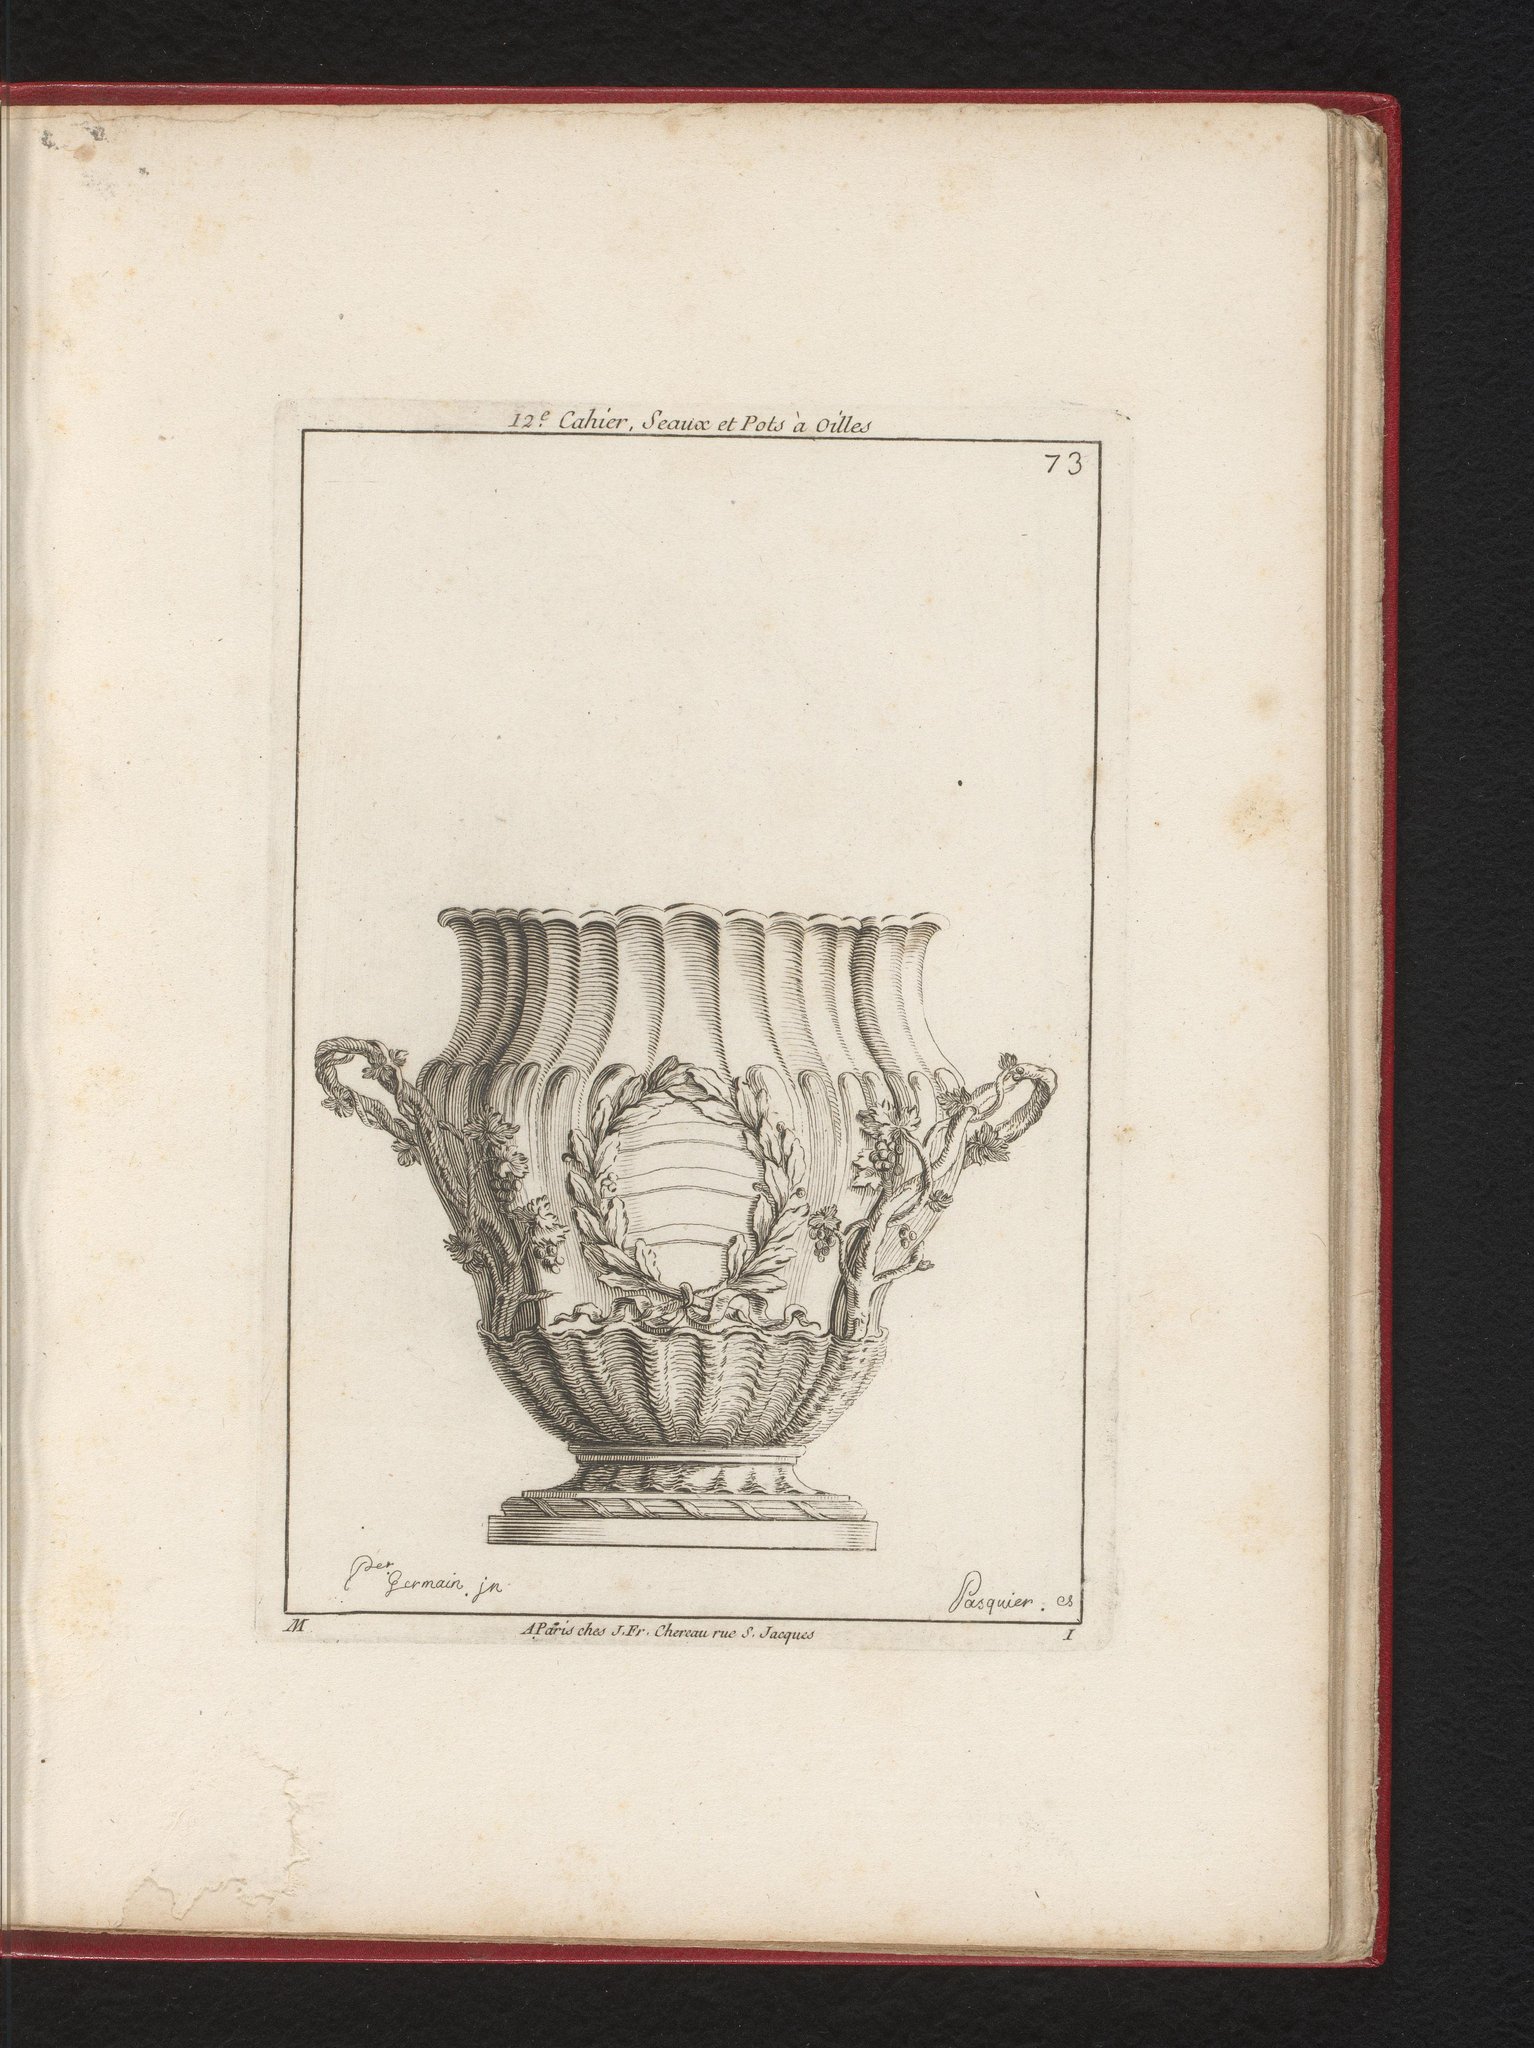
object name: album leaf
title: 12e cahier, seaux et pots à oilles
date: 1748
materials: paper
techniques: etching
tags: wine-cooler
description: Een aantal van de objecten in deze reeks heeft een eigen ondertitel, die verwijst naar genummerde 'cahiers' (afleveringen) waarin de prenten werden uitgegeven. Het is onduidelijk welke objecten recies bij welke aflevering horen. Daarom is die ondertitel enkel verwerkt bij de prent waarop die voorkomt.